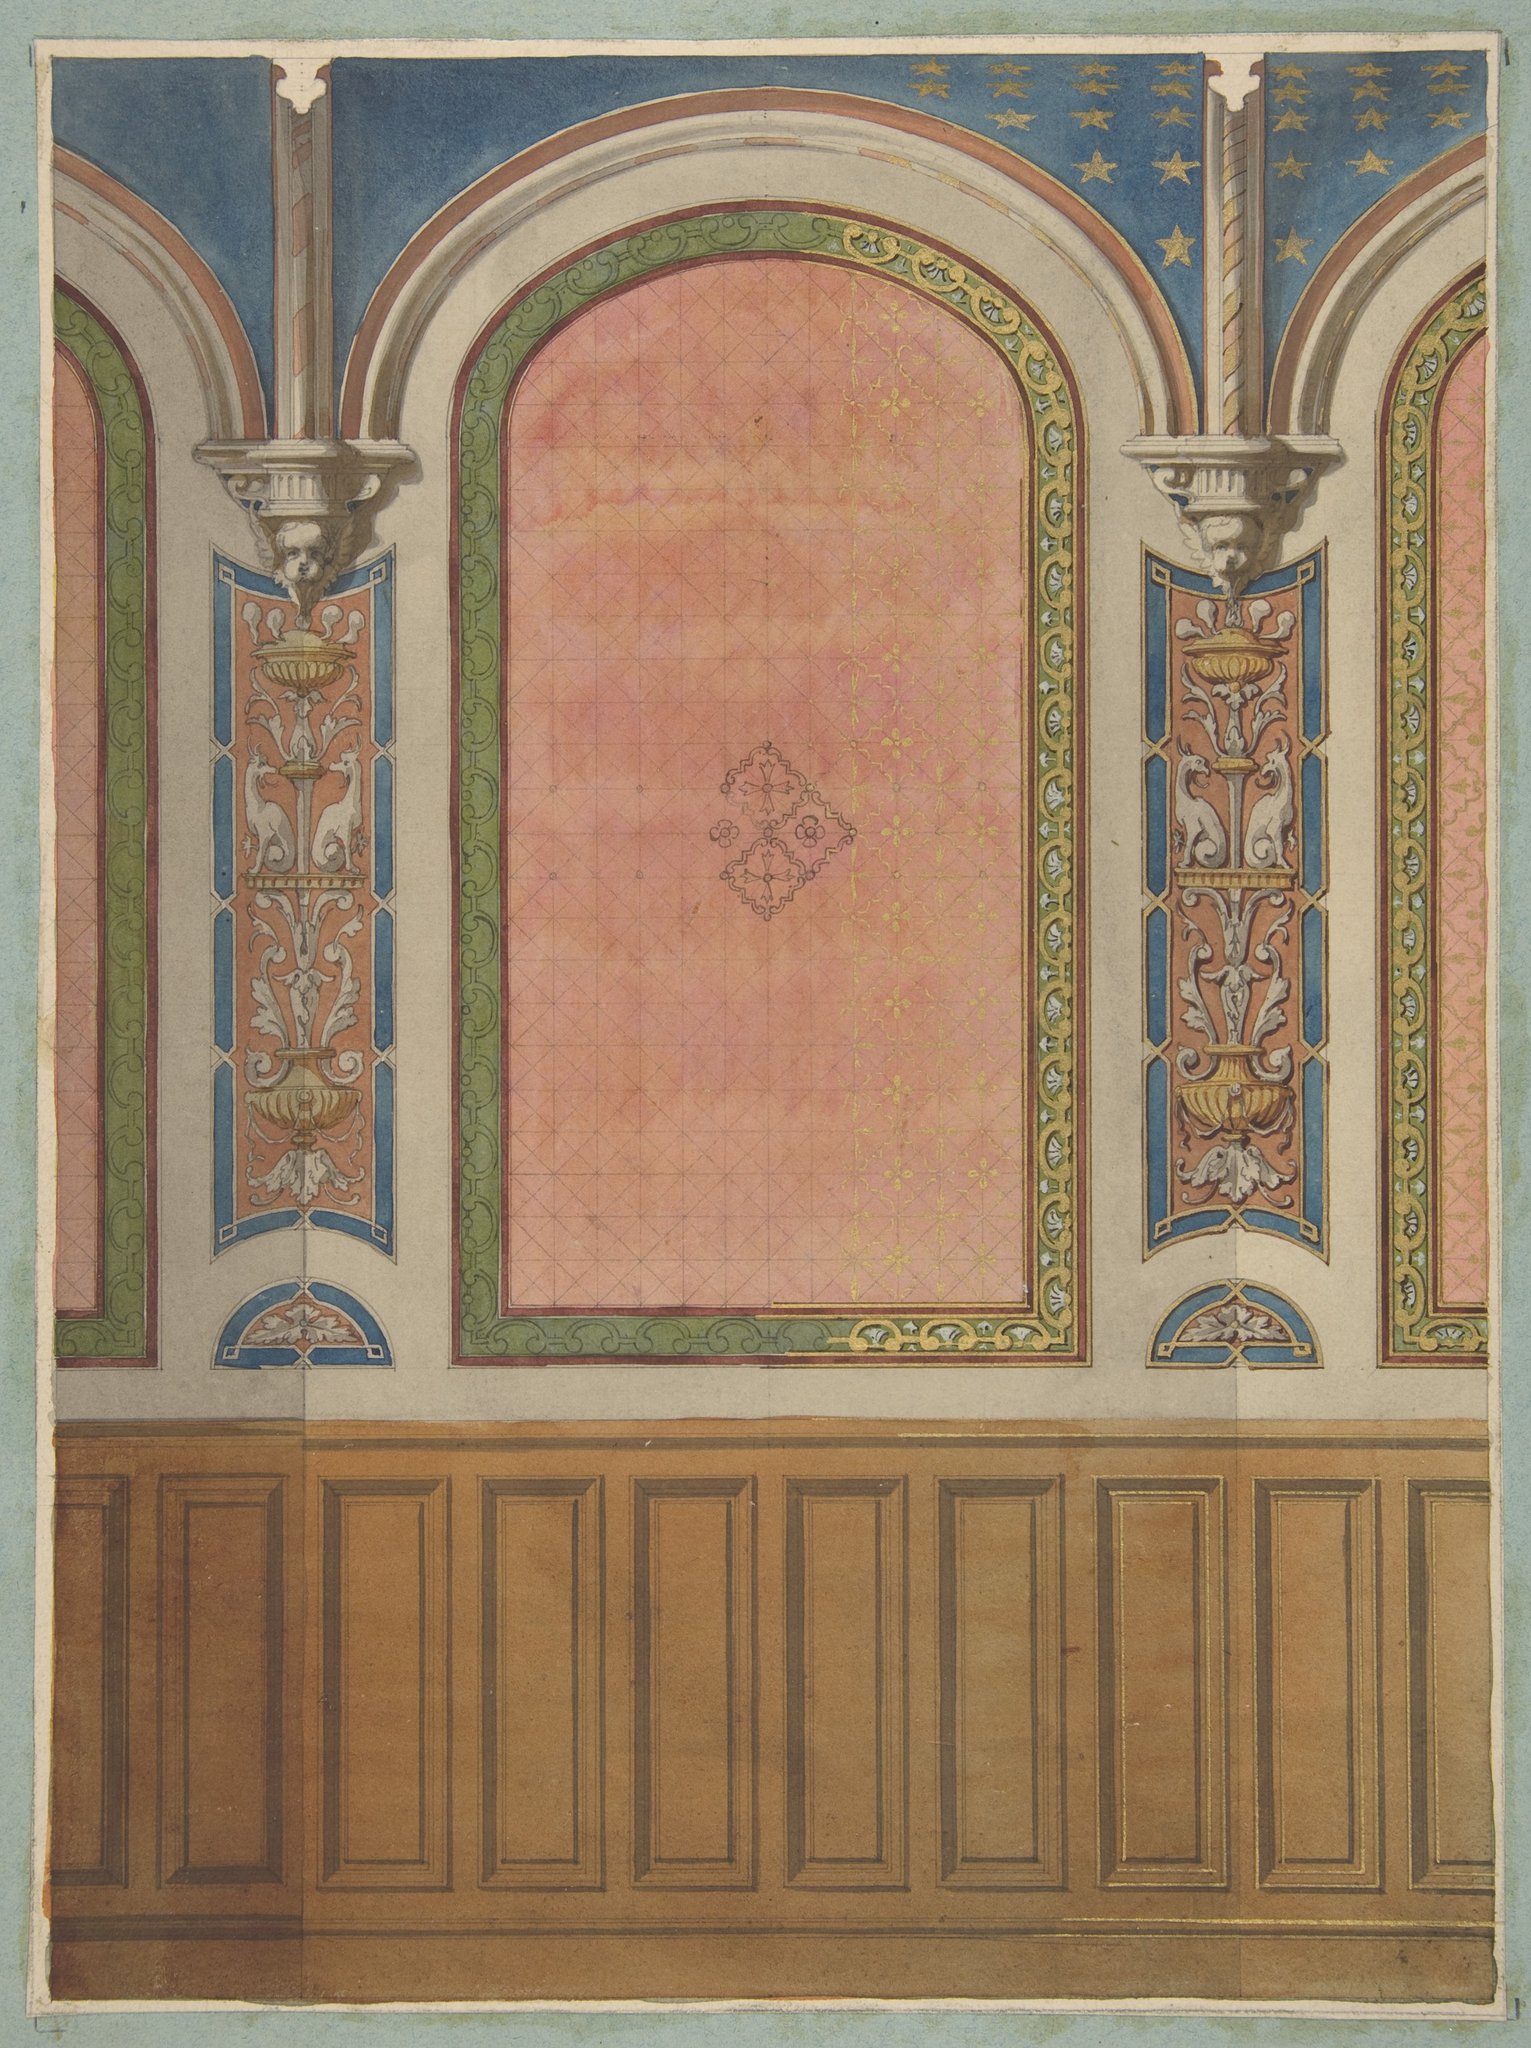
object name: drawing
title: Design for the decoration of wall with wood panels and arched bays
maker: jules-edmond-charles lachaise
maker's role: artist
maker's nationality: french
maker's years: 1897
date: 1851-1900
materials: gold paint, gouache, graphite, ink, watercolor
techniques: pen